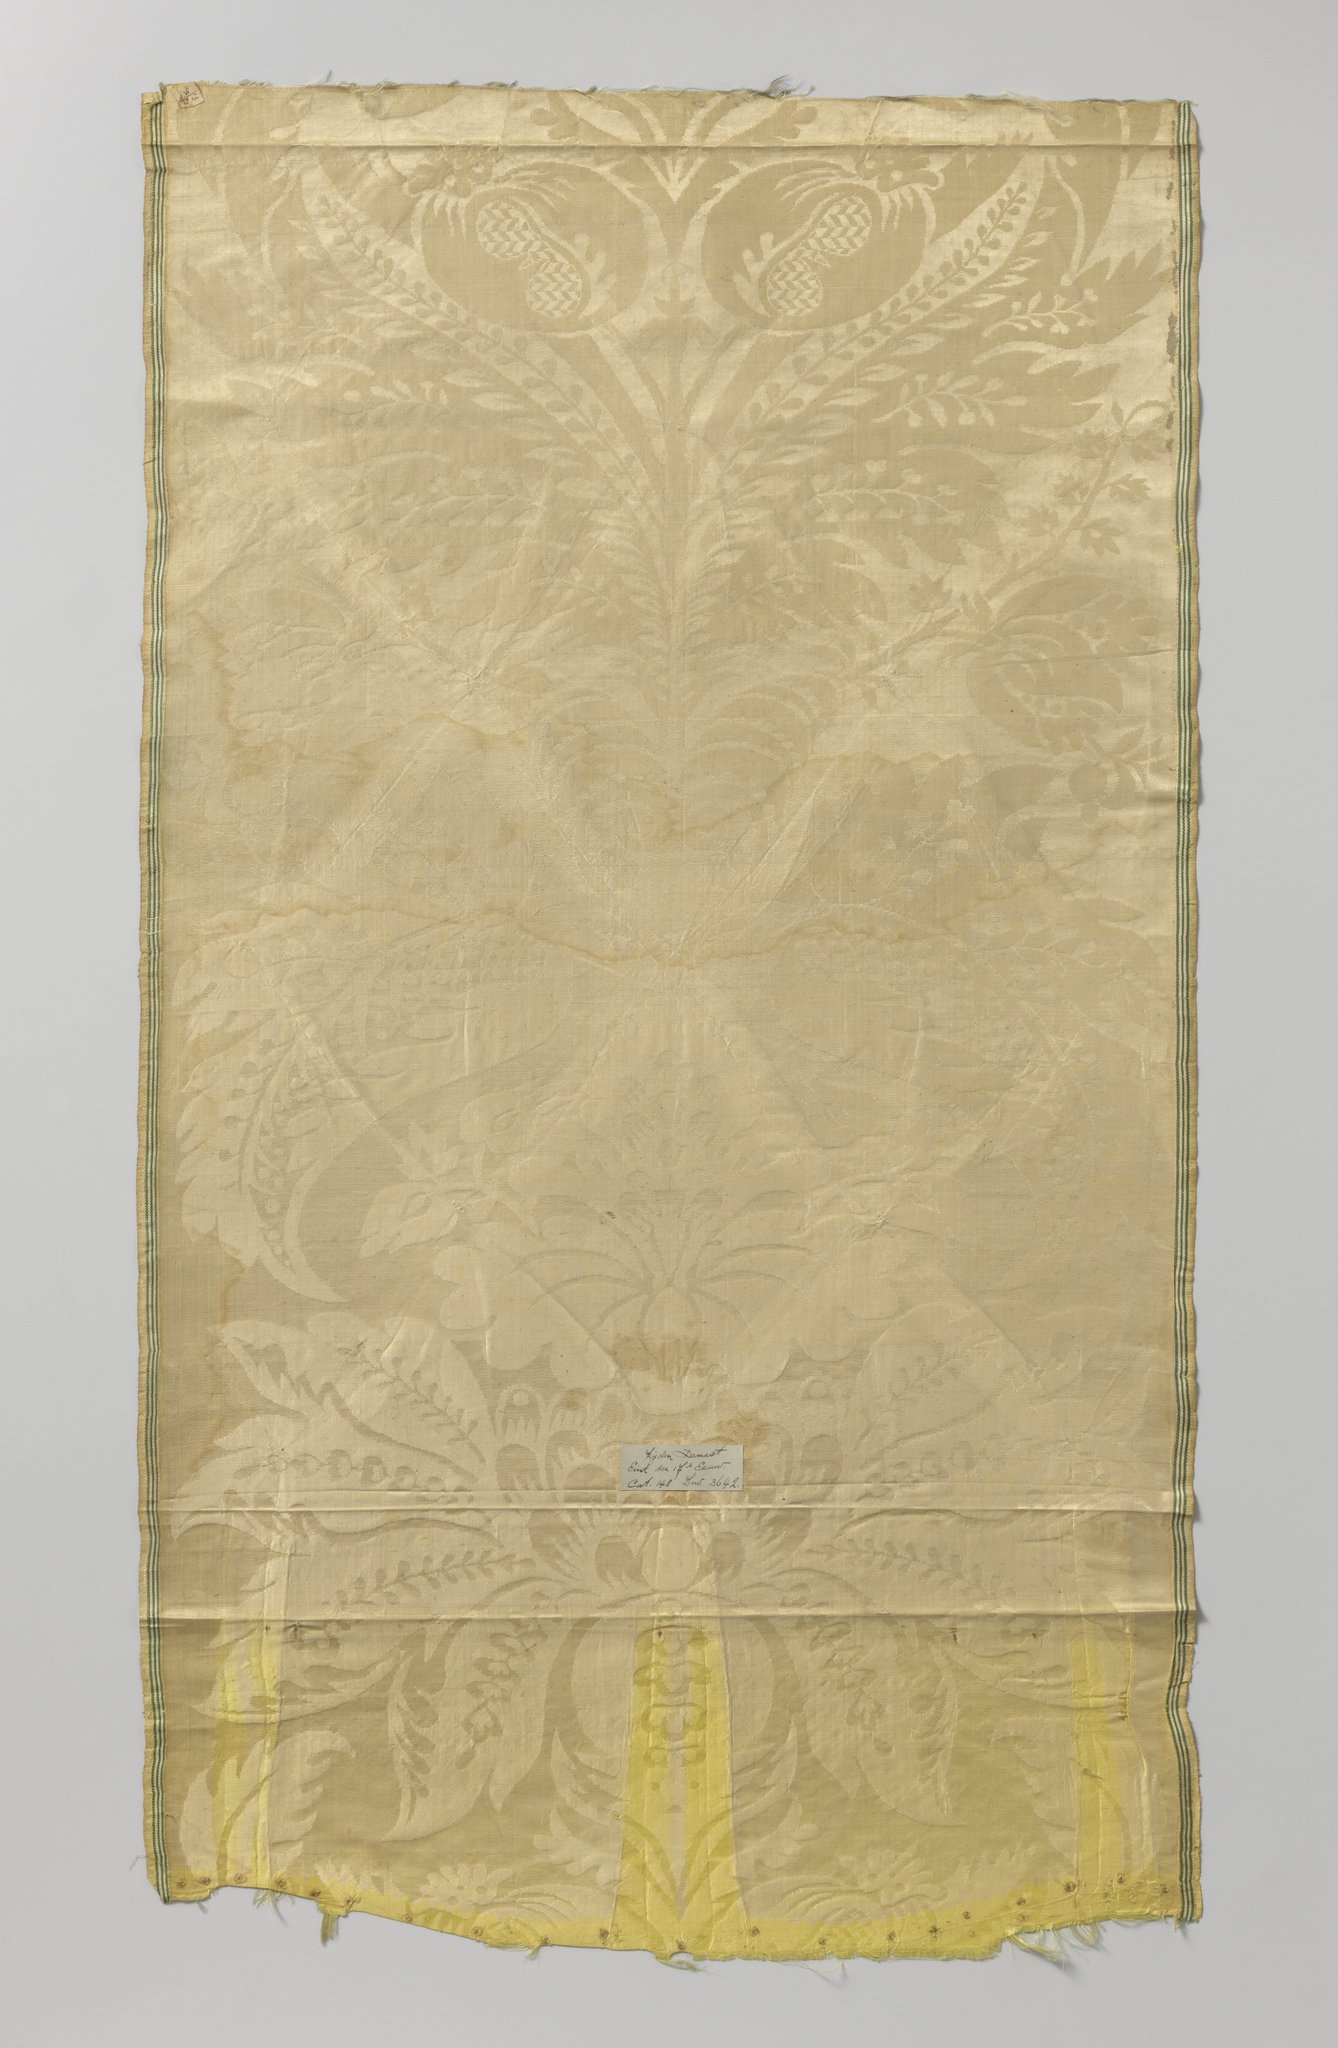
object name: zijdedamast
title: Fragment van gele zijden damast met groot patroon van gestileerde waaiervormig gespreide bladeren tussen bloemen en vruchten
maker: Anonymous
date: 1740-1760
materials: silk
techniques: damask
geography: germany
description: Fragment van gele zijden damast met groot patroon van gestileerde waaiervormig gespreide bladeren tussen bloemen en vruchten.